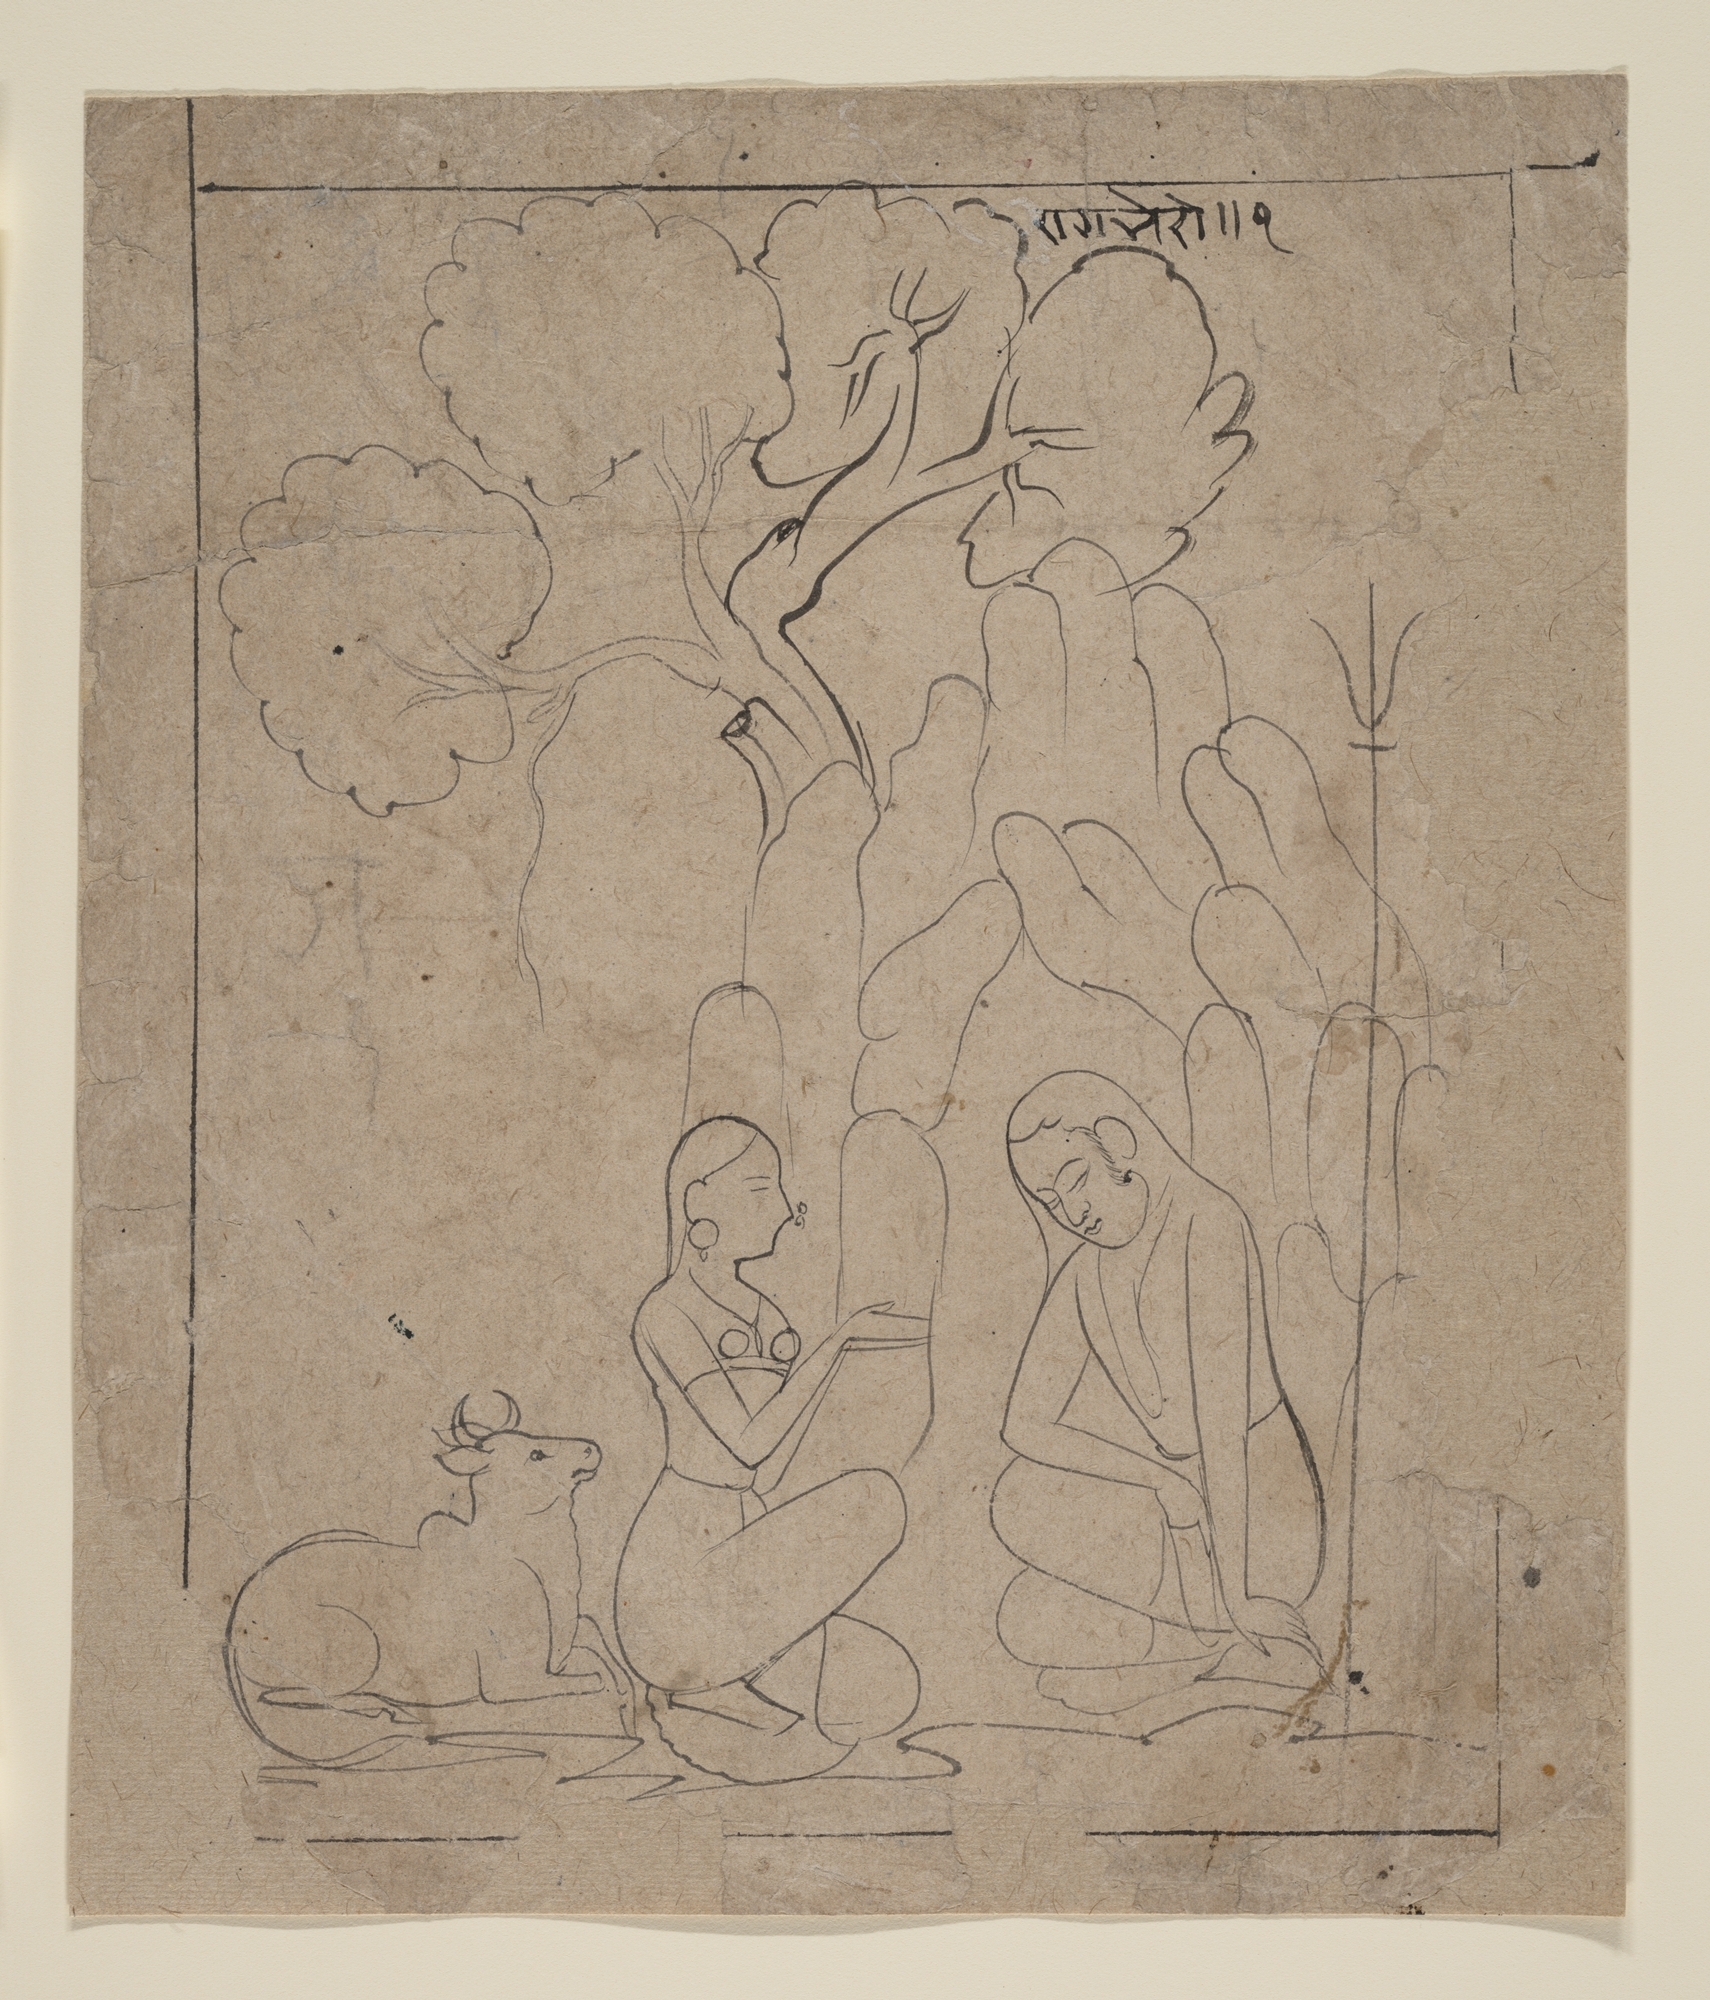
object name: drawing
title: Shiva and Parvati in a Mountain Grotto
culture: indian, guler, pahari hills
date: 1800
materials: ink, paper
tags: cows,parvati,shiva